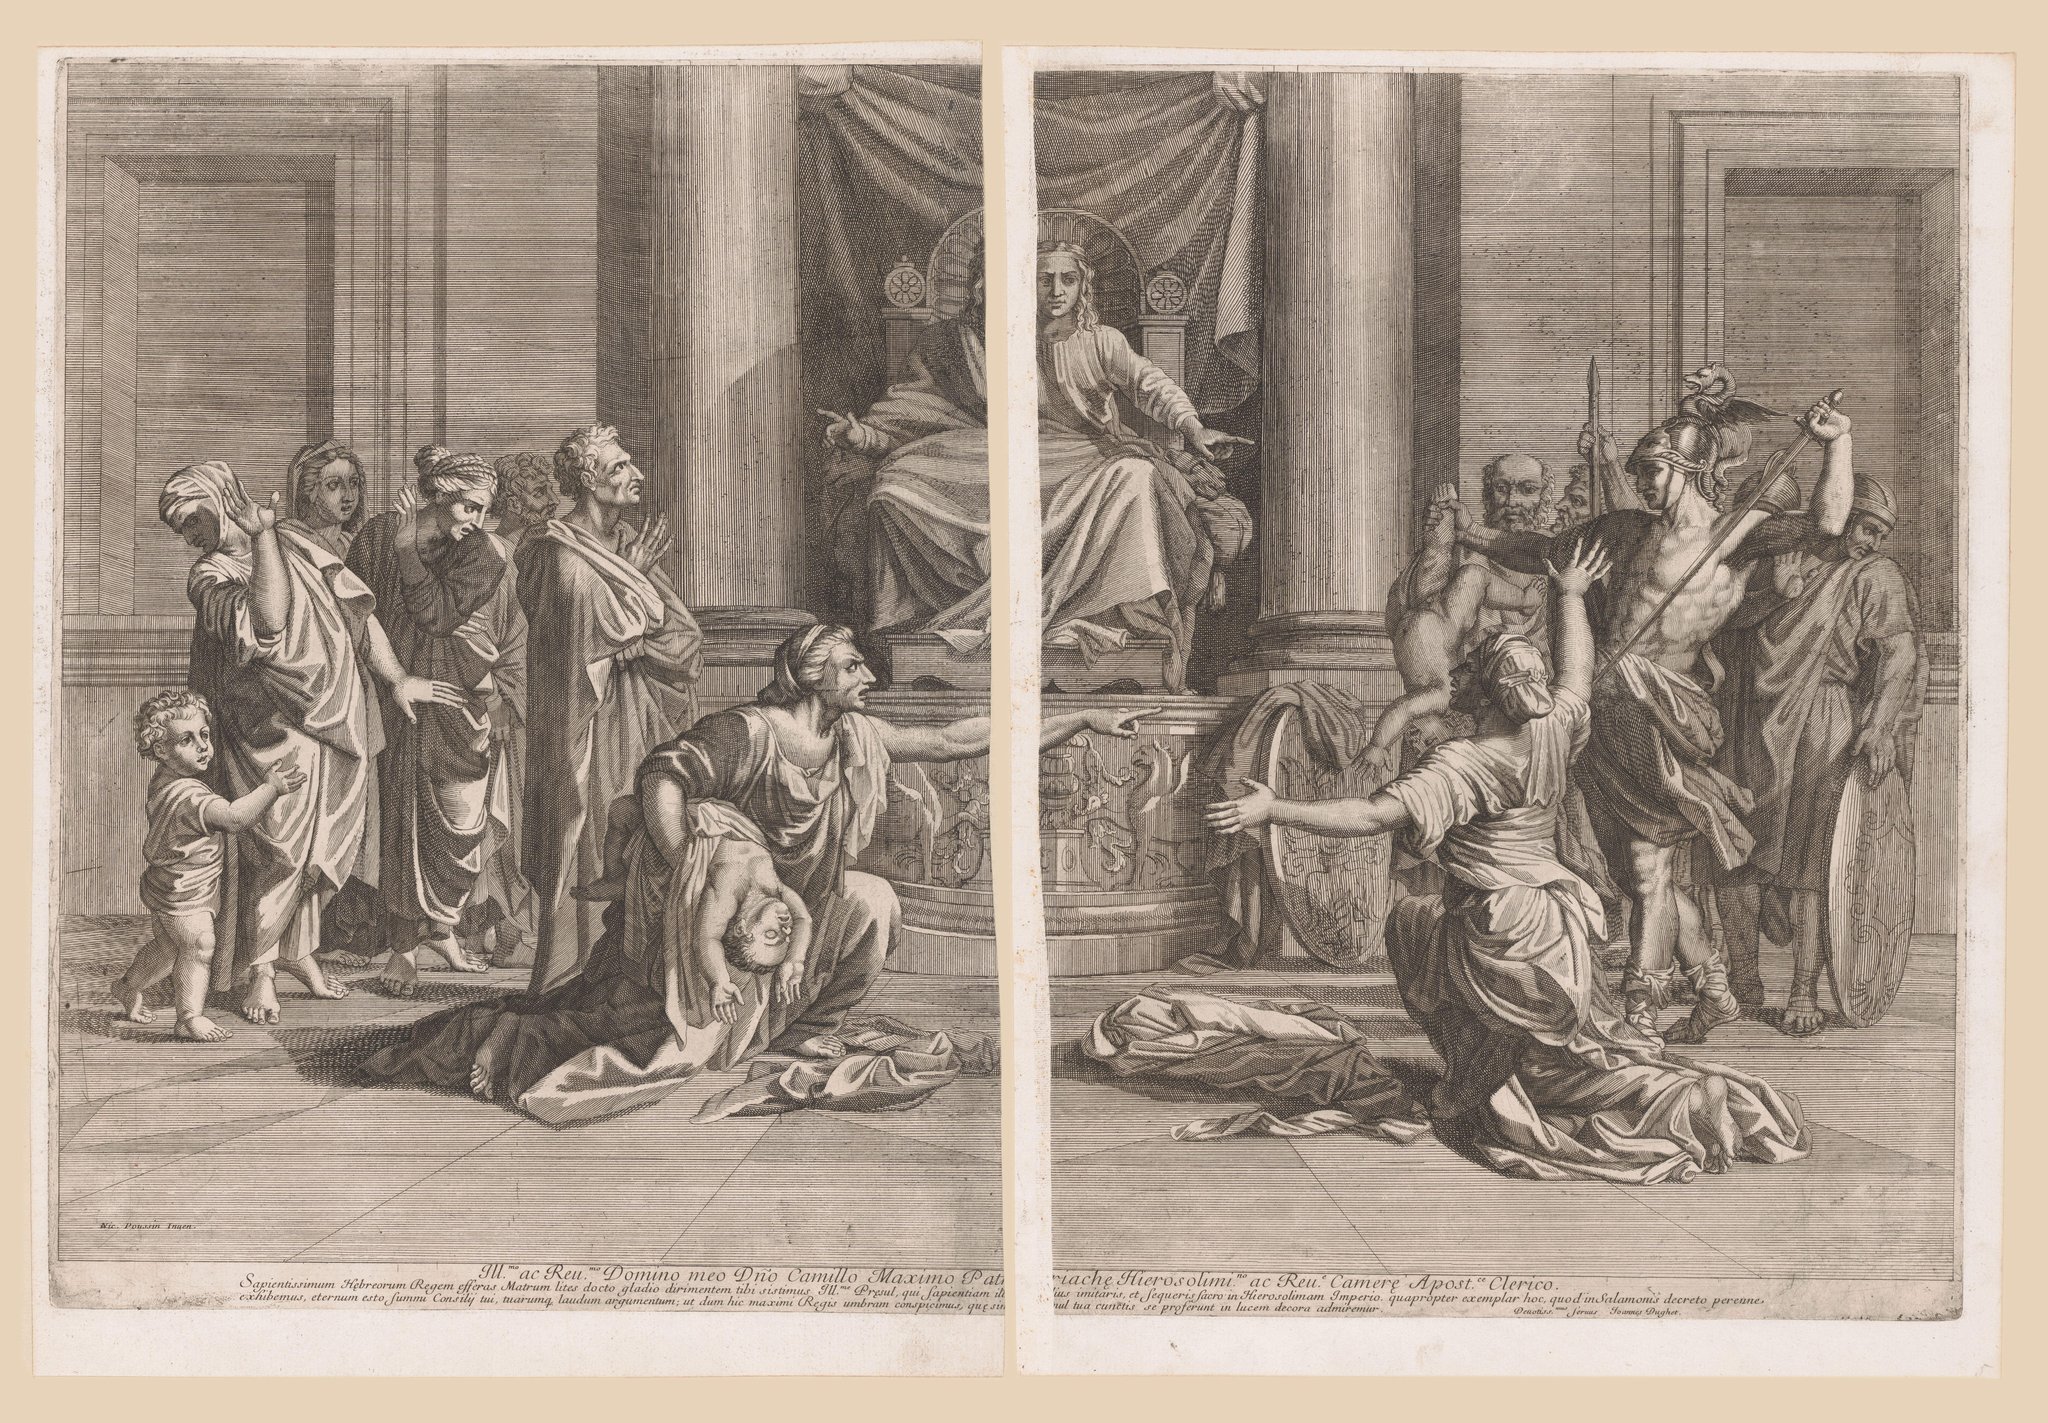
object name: print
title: Oordeel van Salomon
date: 1670-1679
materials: paper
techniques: engraving, etching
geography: rome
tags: solomon gives verdict; he commands a soldier to divide the living child in two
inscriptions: collector's mark: Lugt 240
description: Dit object is omwille van een betere presentatie virtueel samengevoegd maar bestaat fysiek uit losse onderdelen.